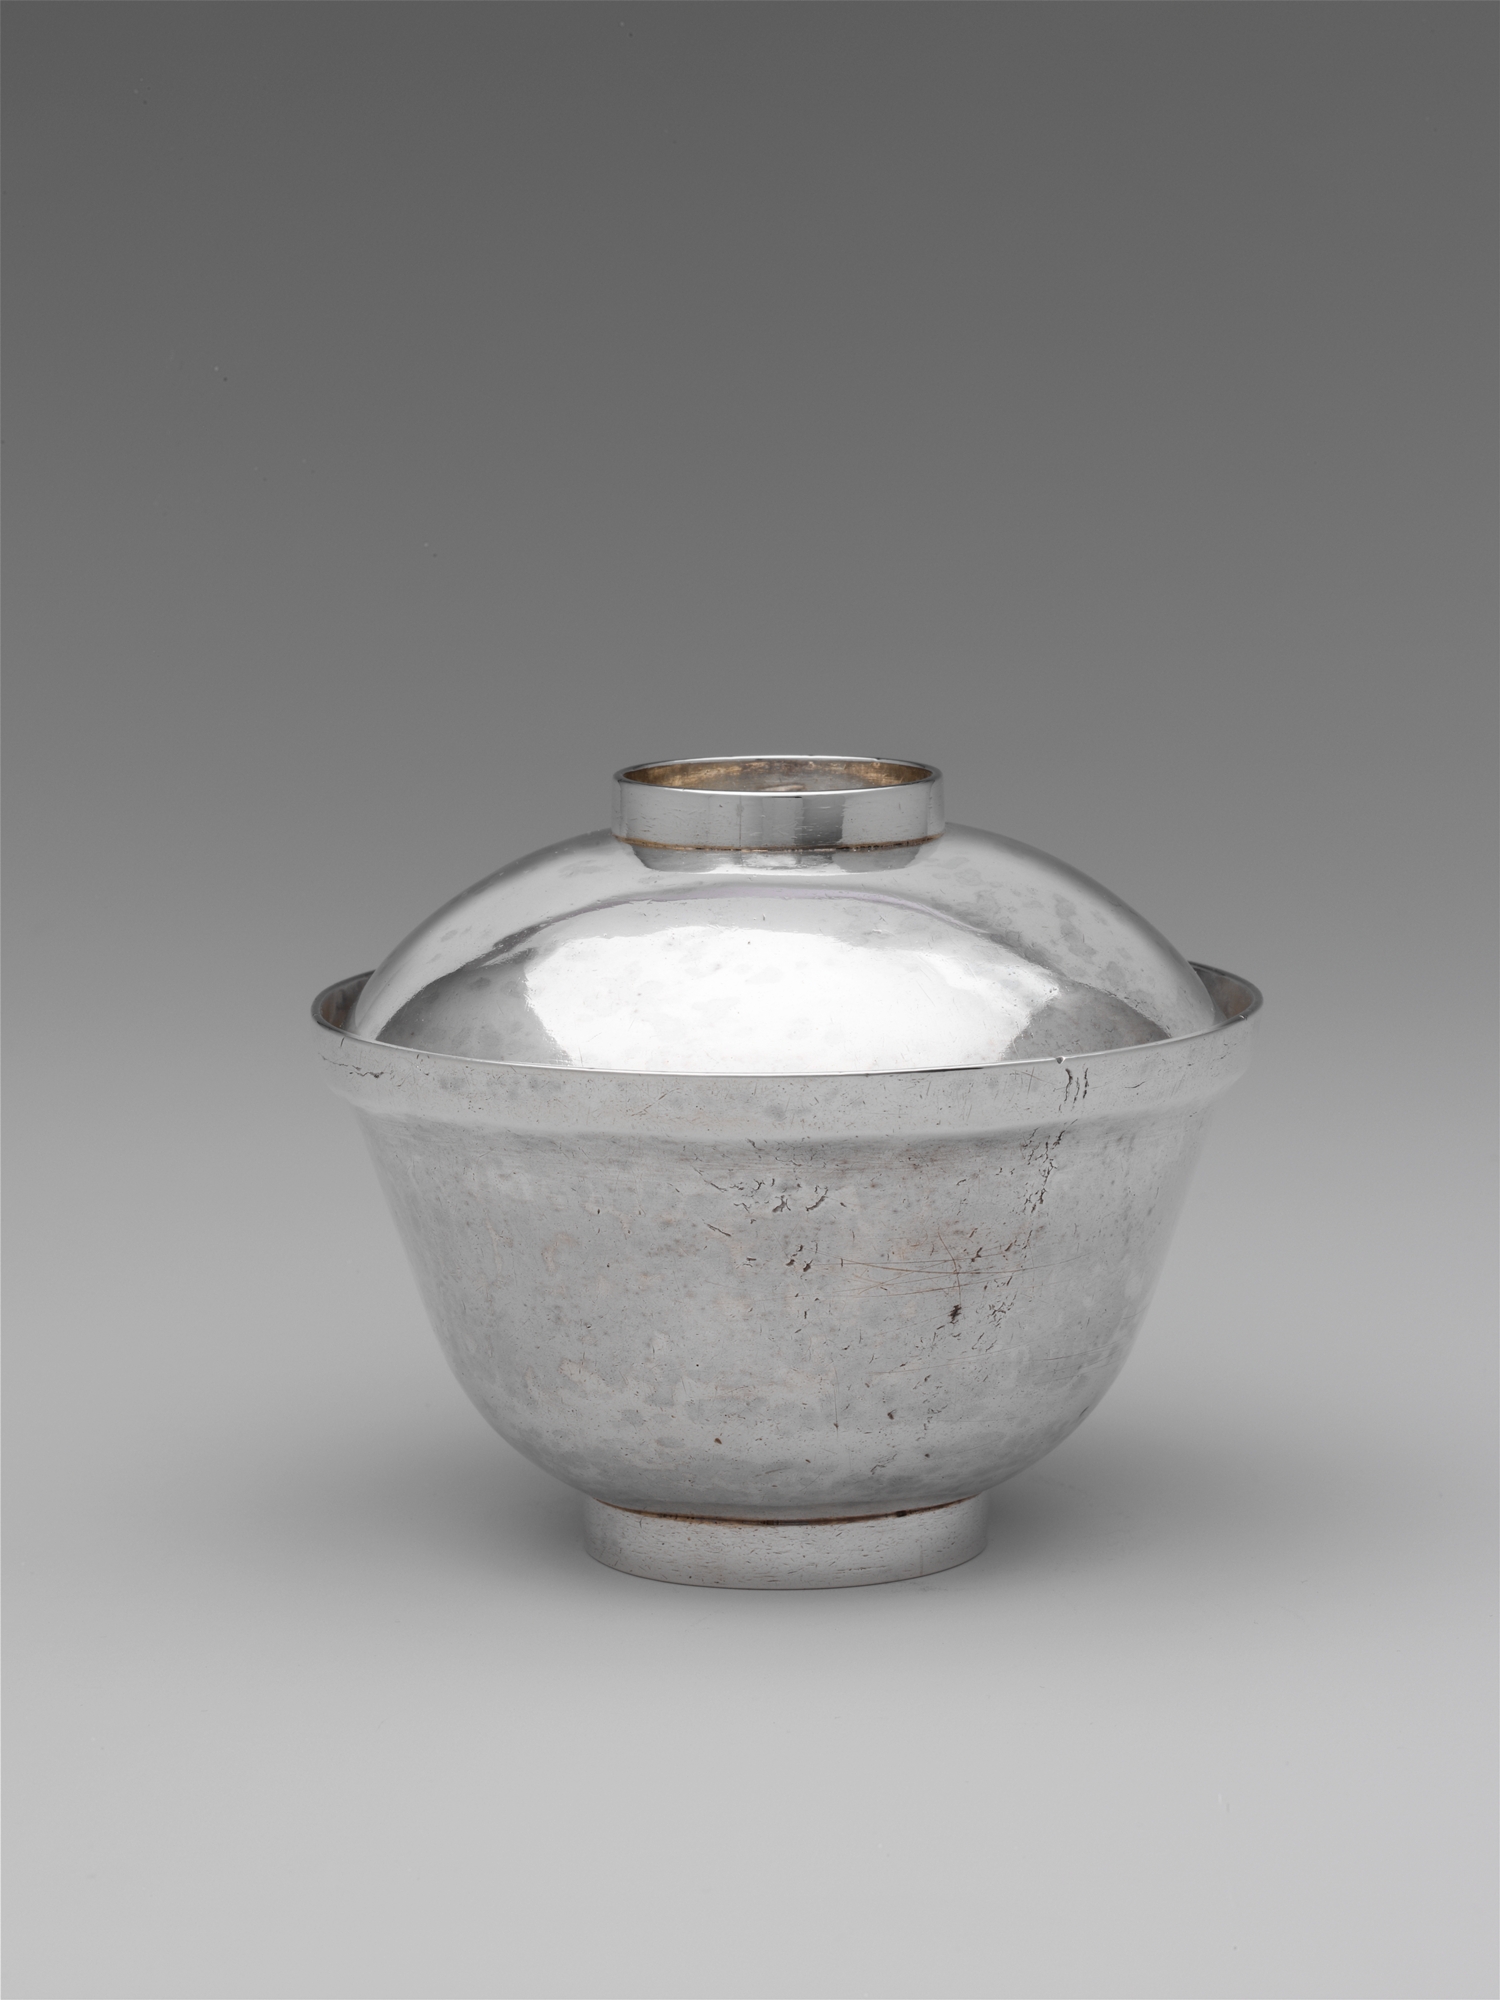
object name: sugar bowl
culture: american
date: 1735-1755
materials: silver